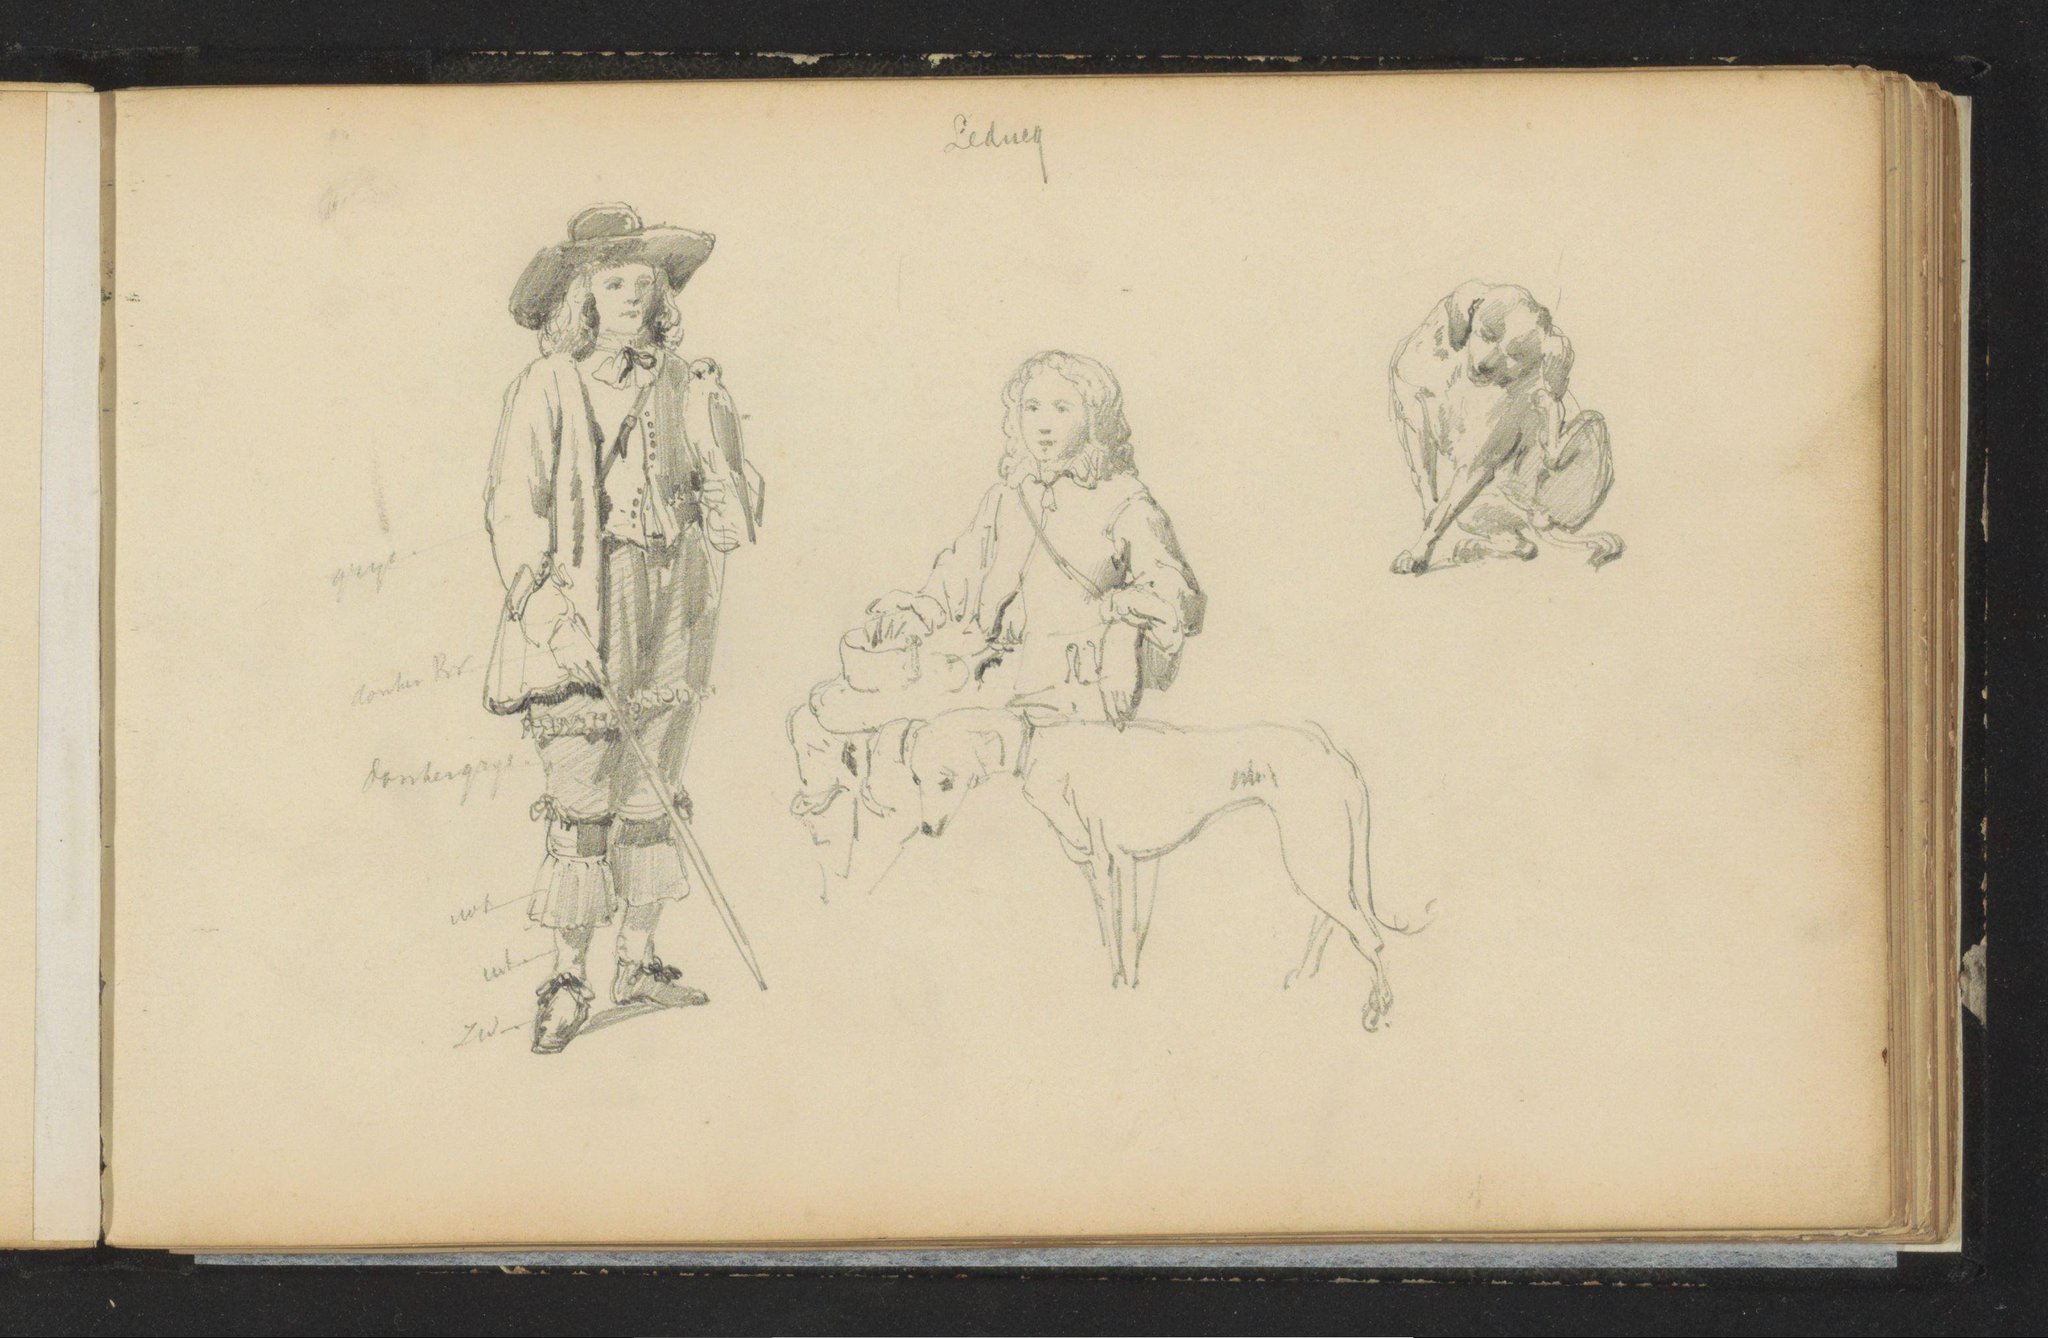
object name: sketchbook leaf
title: Twee jongens en twee honden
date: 1846-1882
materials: paper, pencil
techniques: stumping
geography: netherlands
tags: boy (child between toddler and youth), dog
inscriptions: annotation: ‘Leducq[?]’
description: Links een staande jongen. Naast hem een zittende jongen met een hoed op zijn schoot. Bij hem een hond. Rechtsboven nog een hond. Blad 38 uit een schetsboek met 91 bladen.